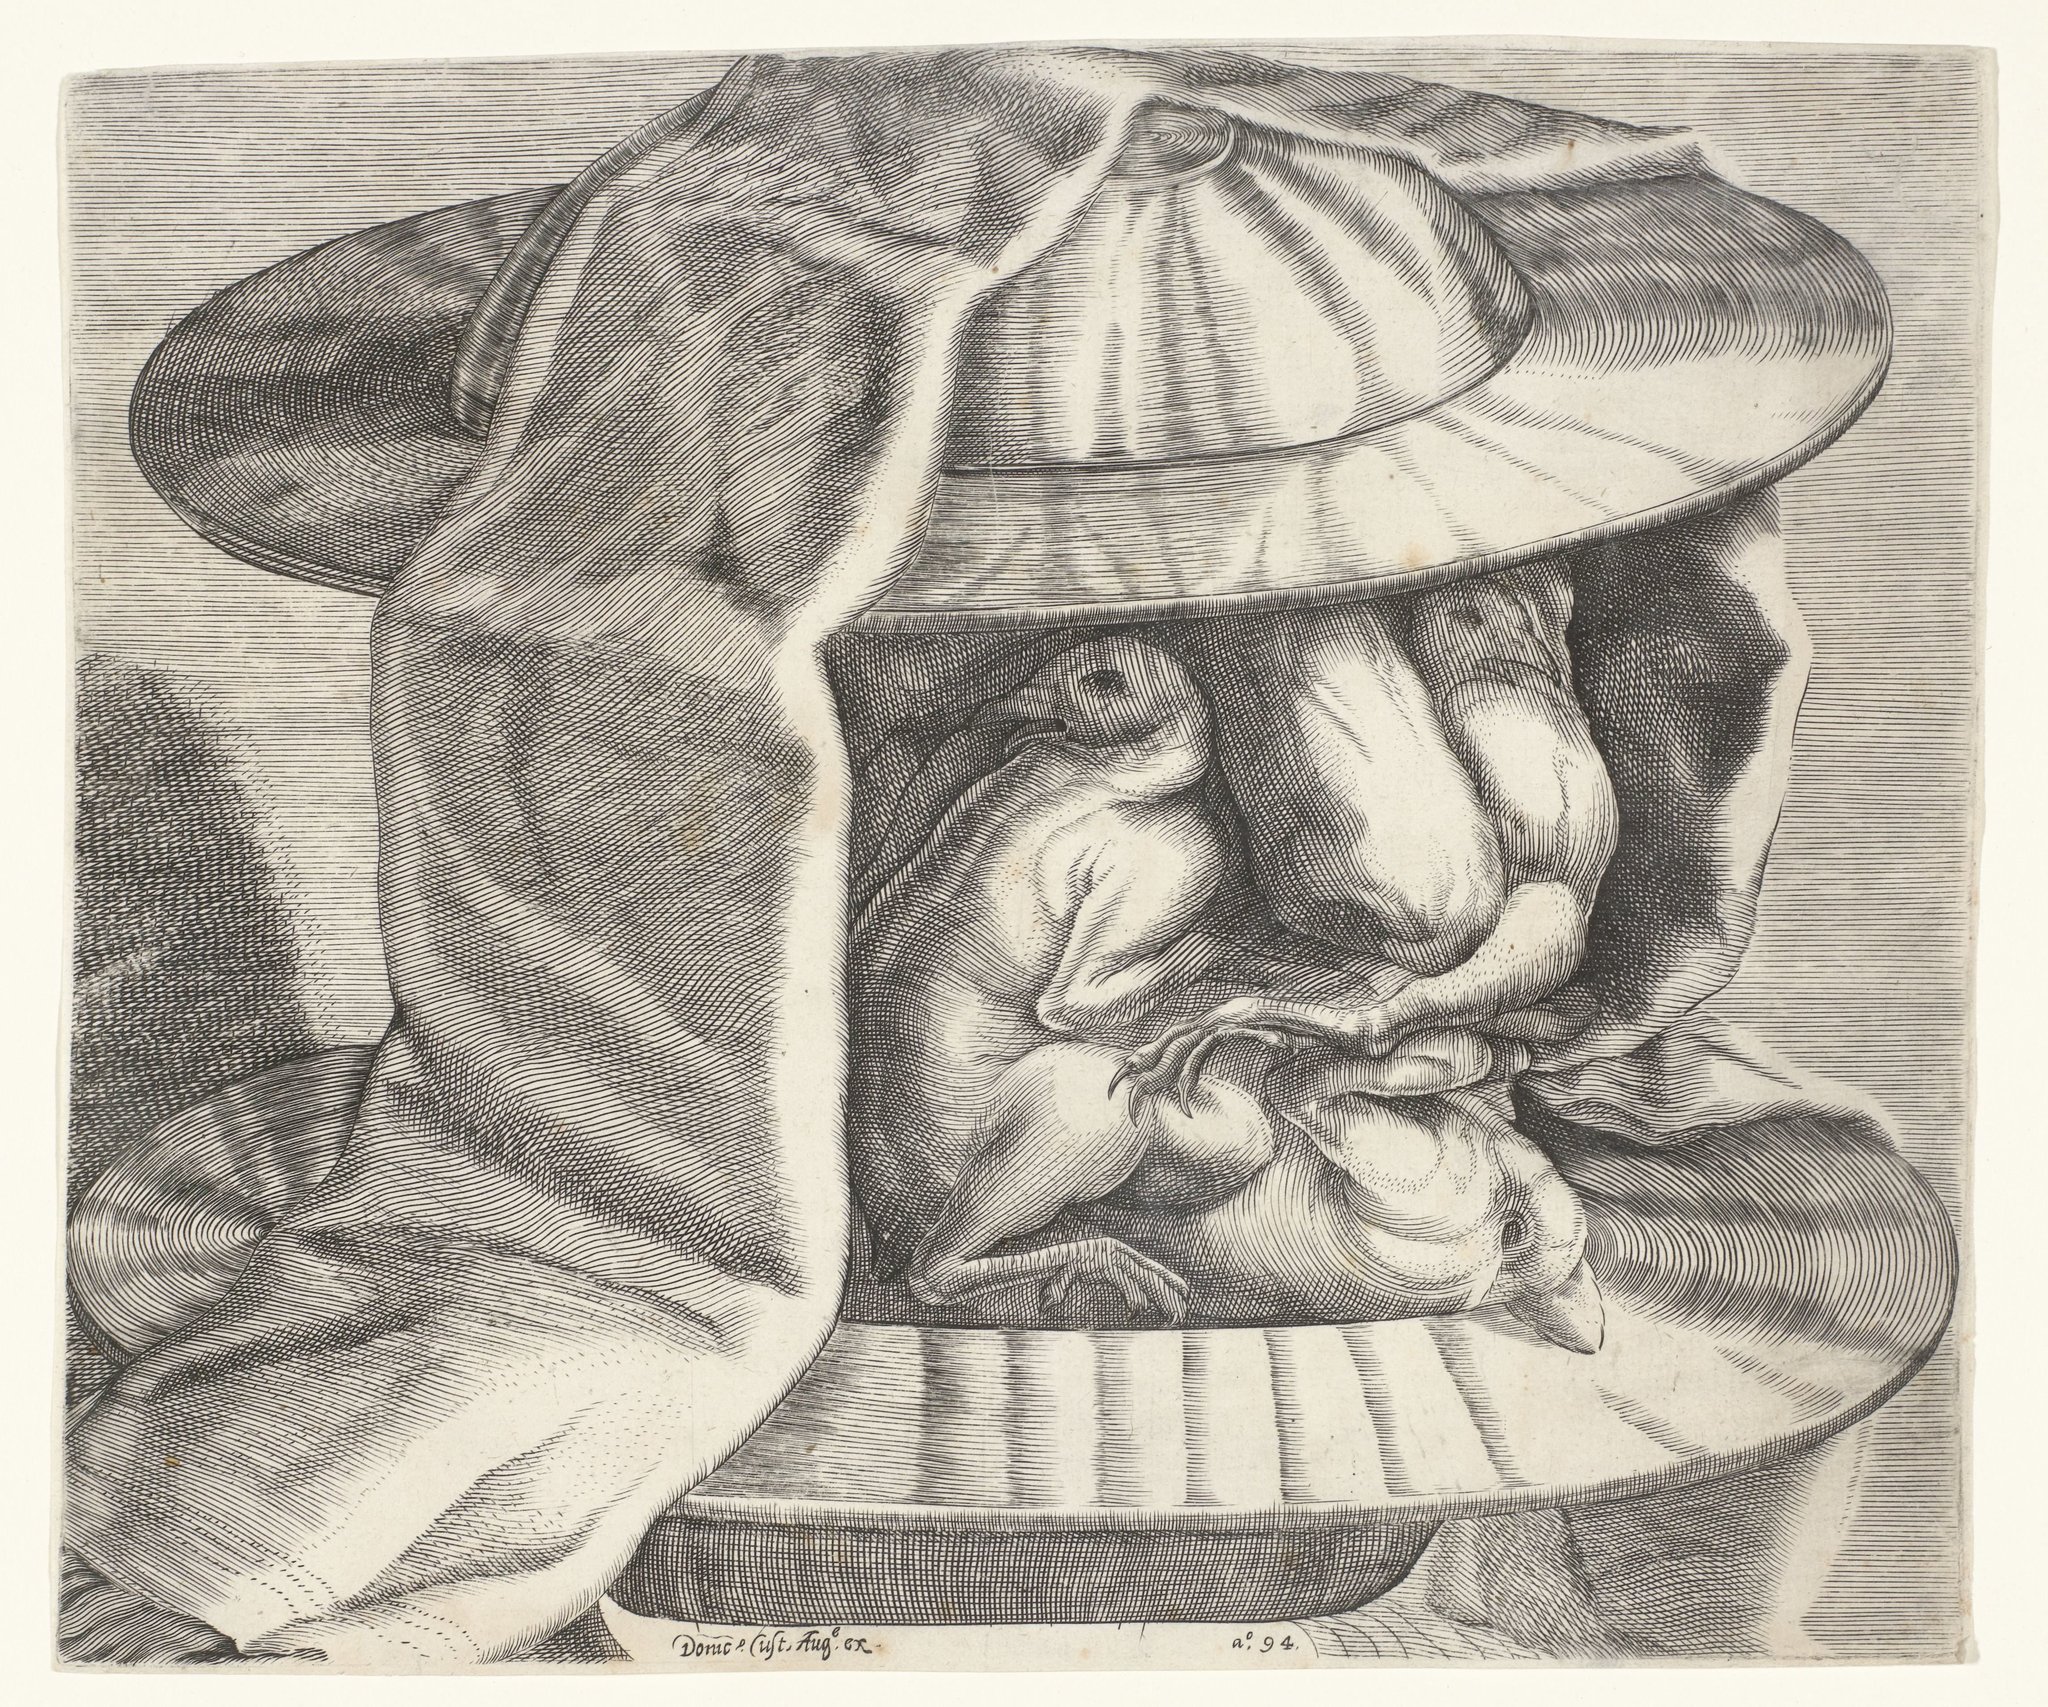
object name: print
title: A Grotesque Head with a Helmet in the Style of Arcimboldo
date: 1594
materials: paper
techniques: engraving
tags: ornament ~ grotesque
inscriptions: watermark: Briquet 2119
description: This imaginary head was devised by the Augsburg printmaker Dominicus Custos. The face consists of roasted poultry between two metal bowls. Two chicken heads serve as eyes, while an outstretched leg suggests a moustache. The composition is strongly reminiscent of paintings by Giuseppe Arcimboldo (c. 1526-1593), who specialized in heads composed of all kinds of vegetables, fruit or roasted game.